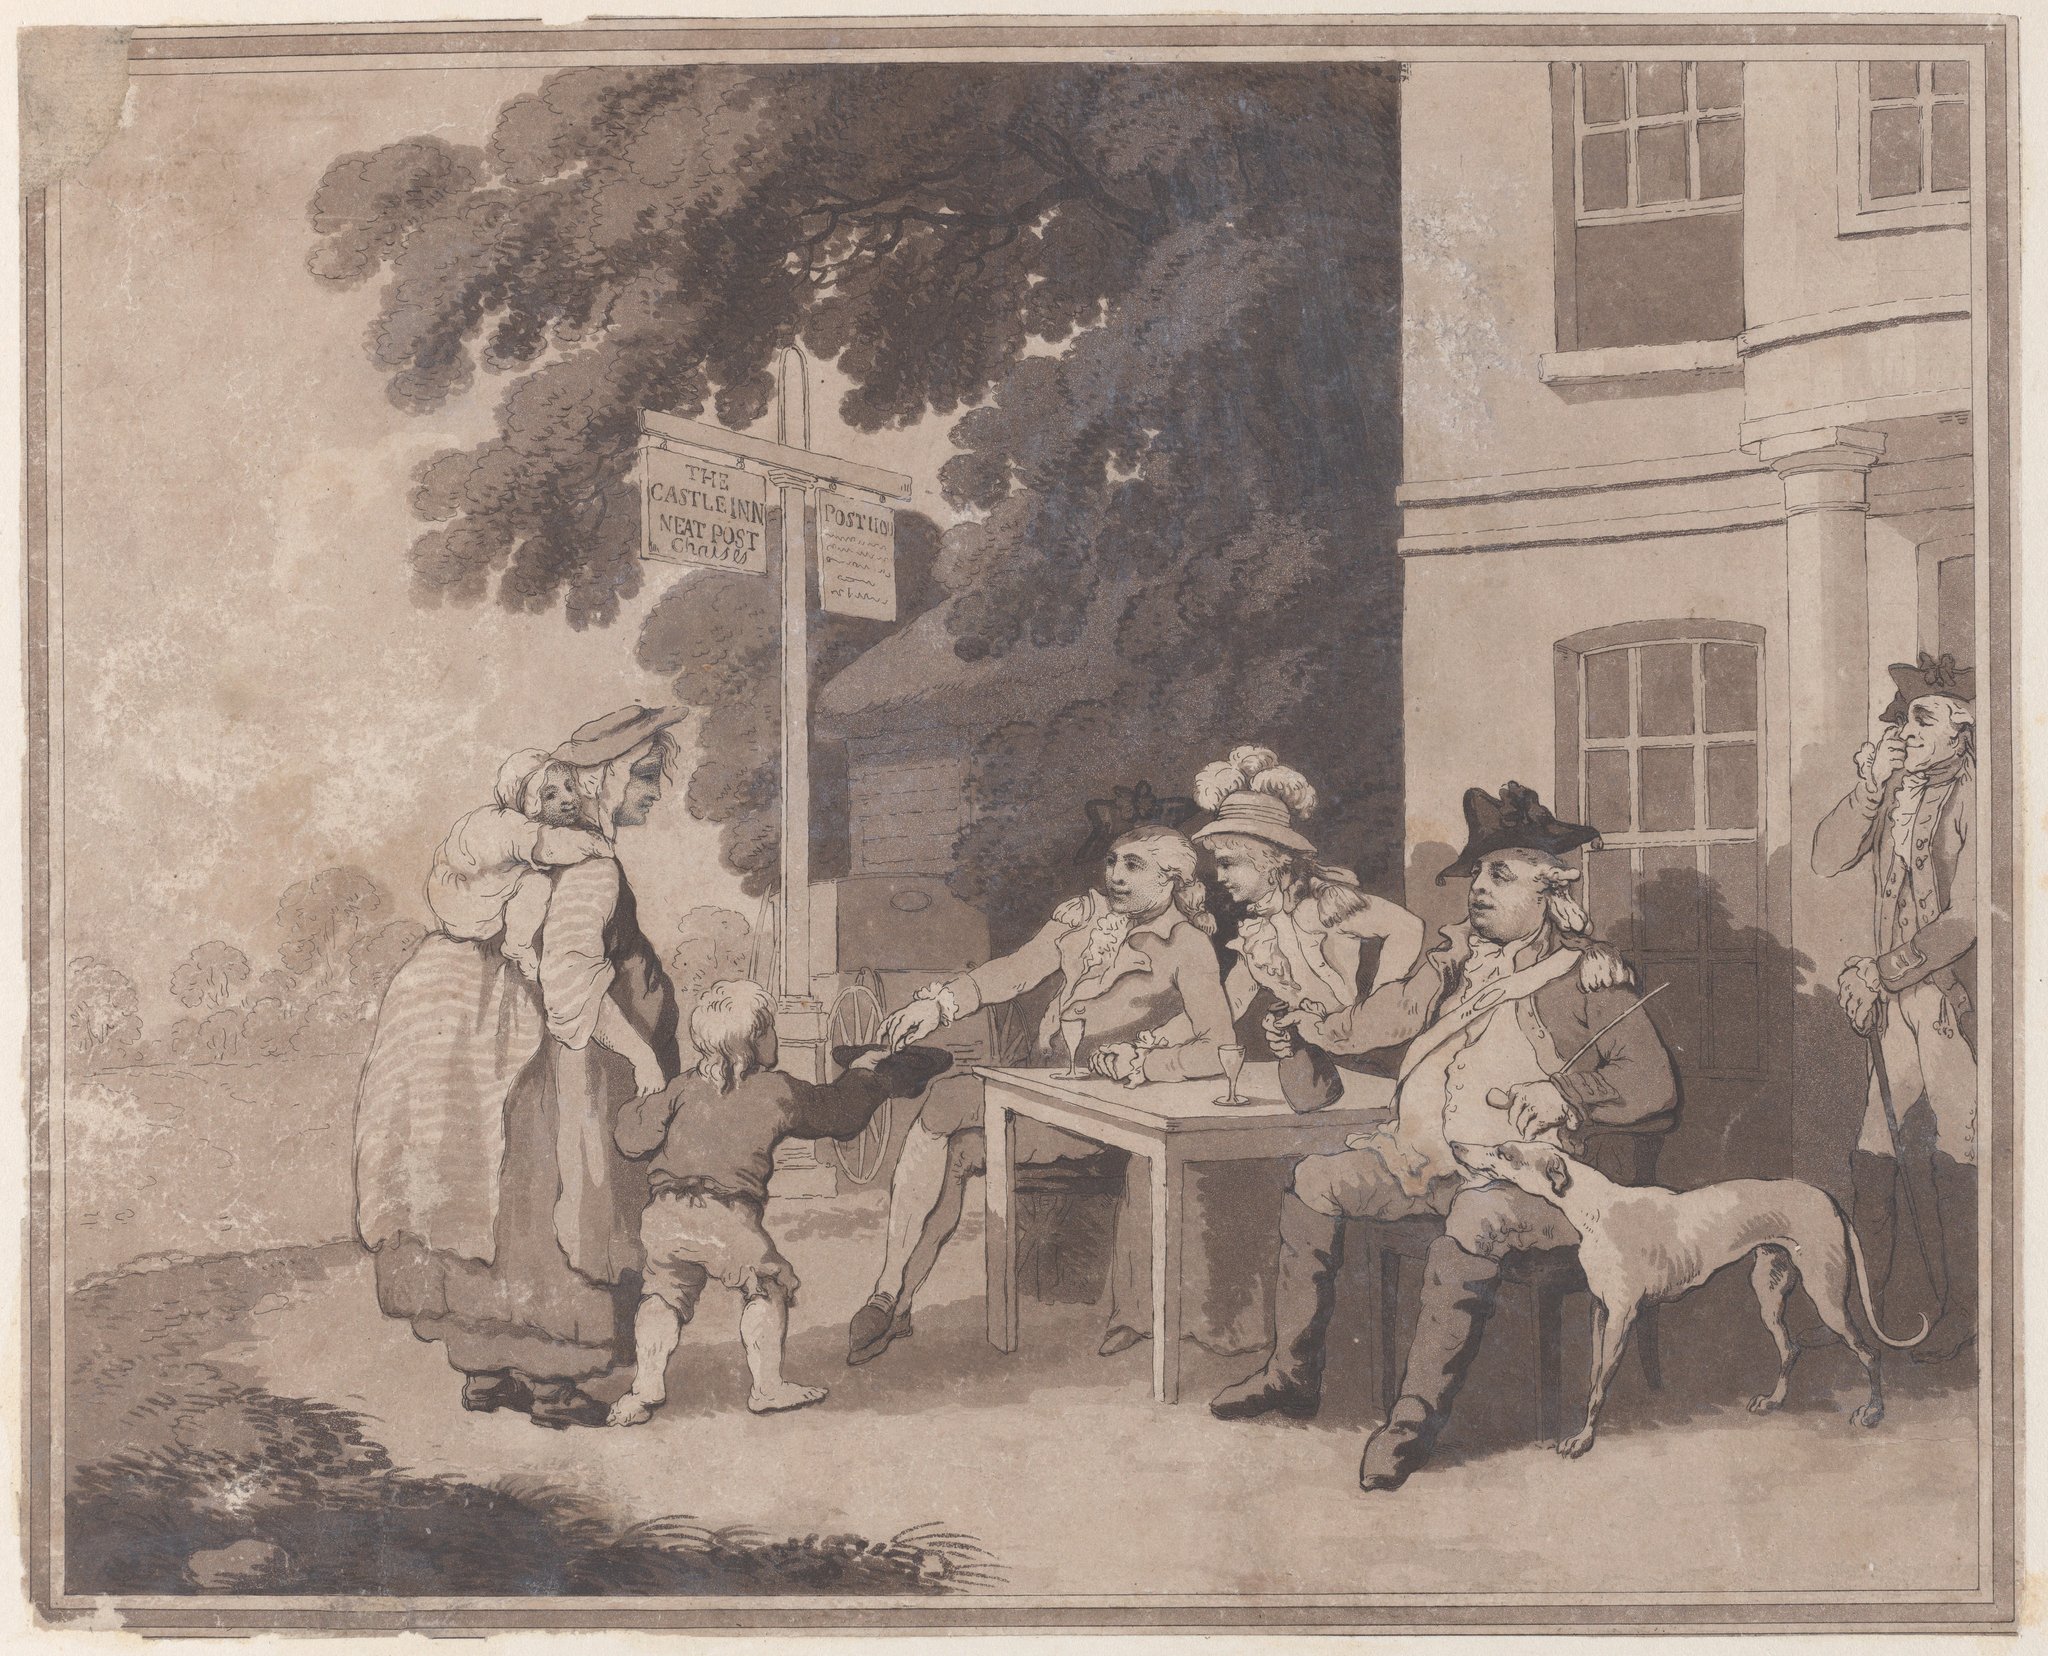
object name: print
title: Benevolence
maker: samuel alken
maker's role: etcher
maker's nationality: british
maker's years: 1756-1815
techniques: aquatint, etching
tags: children,men,women,dogs,drinking